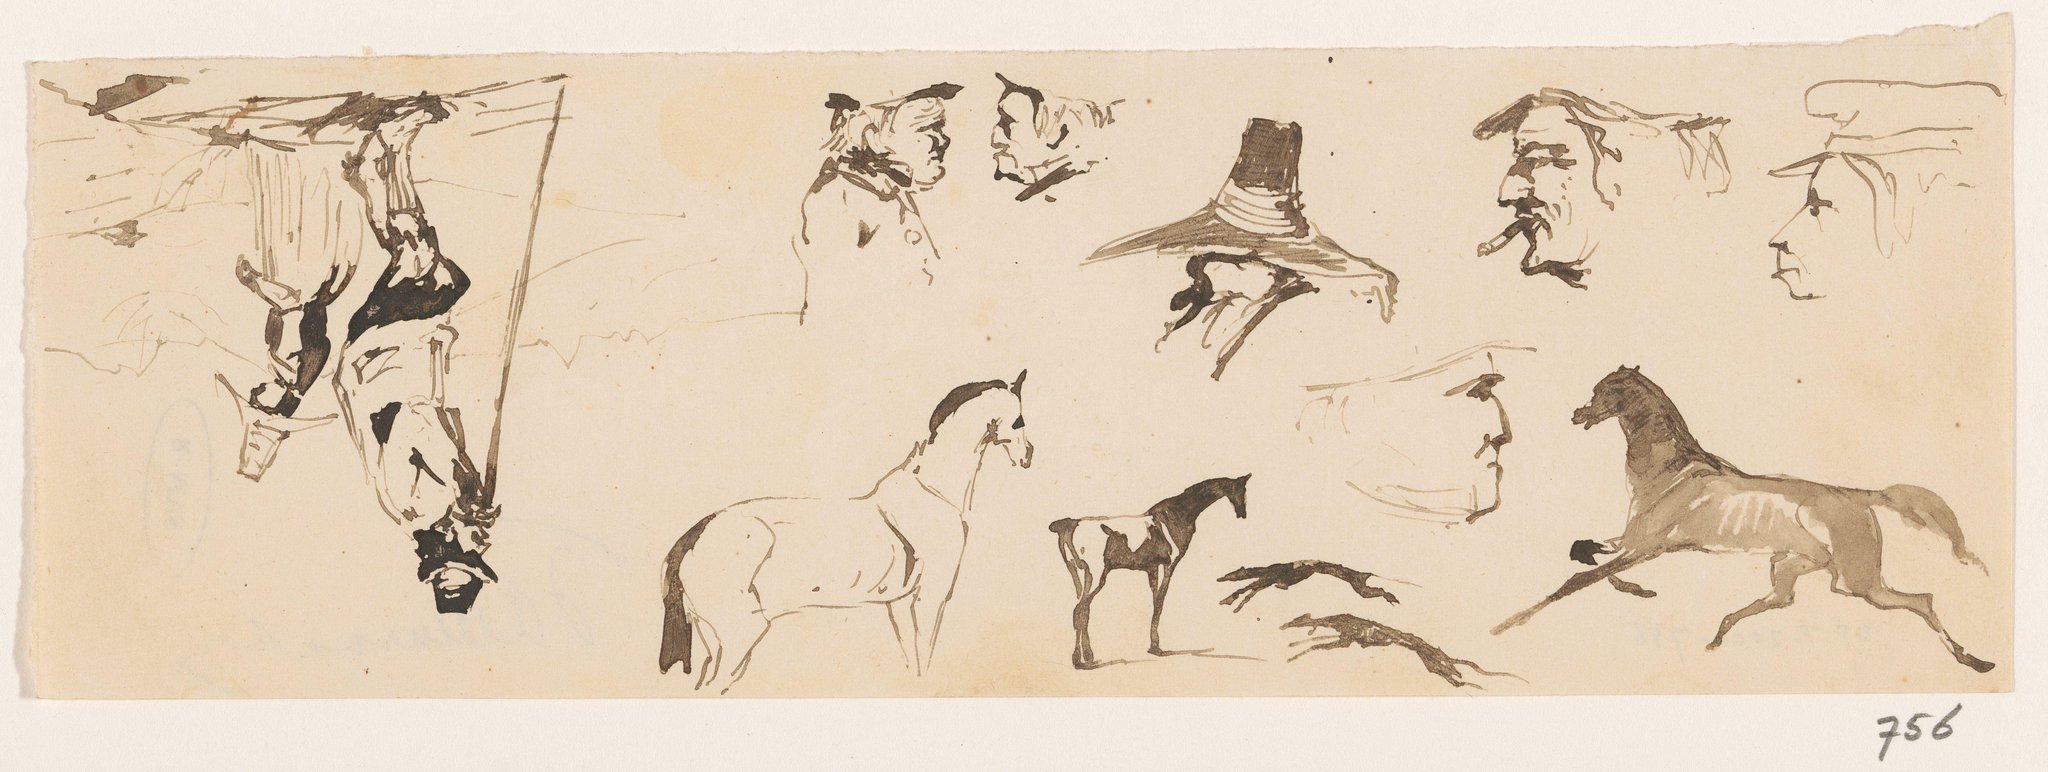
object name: drawing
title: Schetsen van paarden, koppen en een man leunend op een stok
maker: johannes tavenraat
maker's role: draughtsman, painter, print maker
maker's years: 1809-1881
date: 1840-1880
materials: ink, paper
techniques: brush, pen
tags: caricatures (human types), horse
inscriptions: collector's mark: Lugt 2228, signature: ‘Tavenraat’